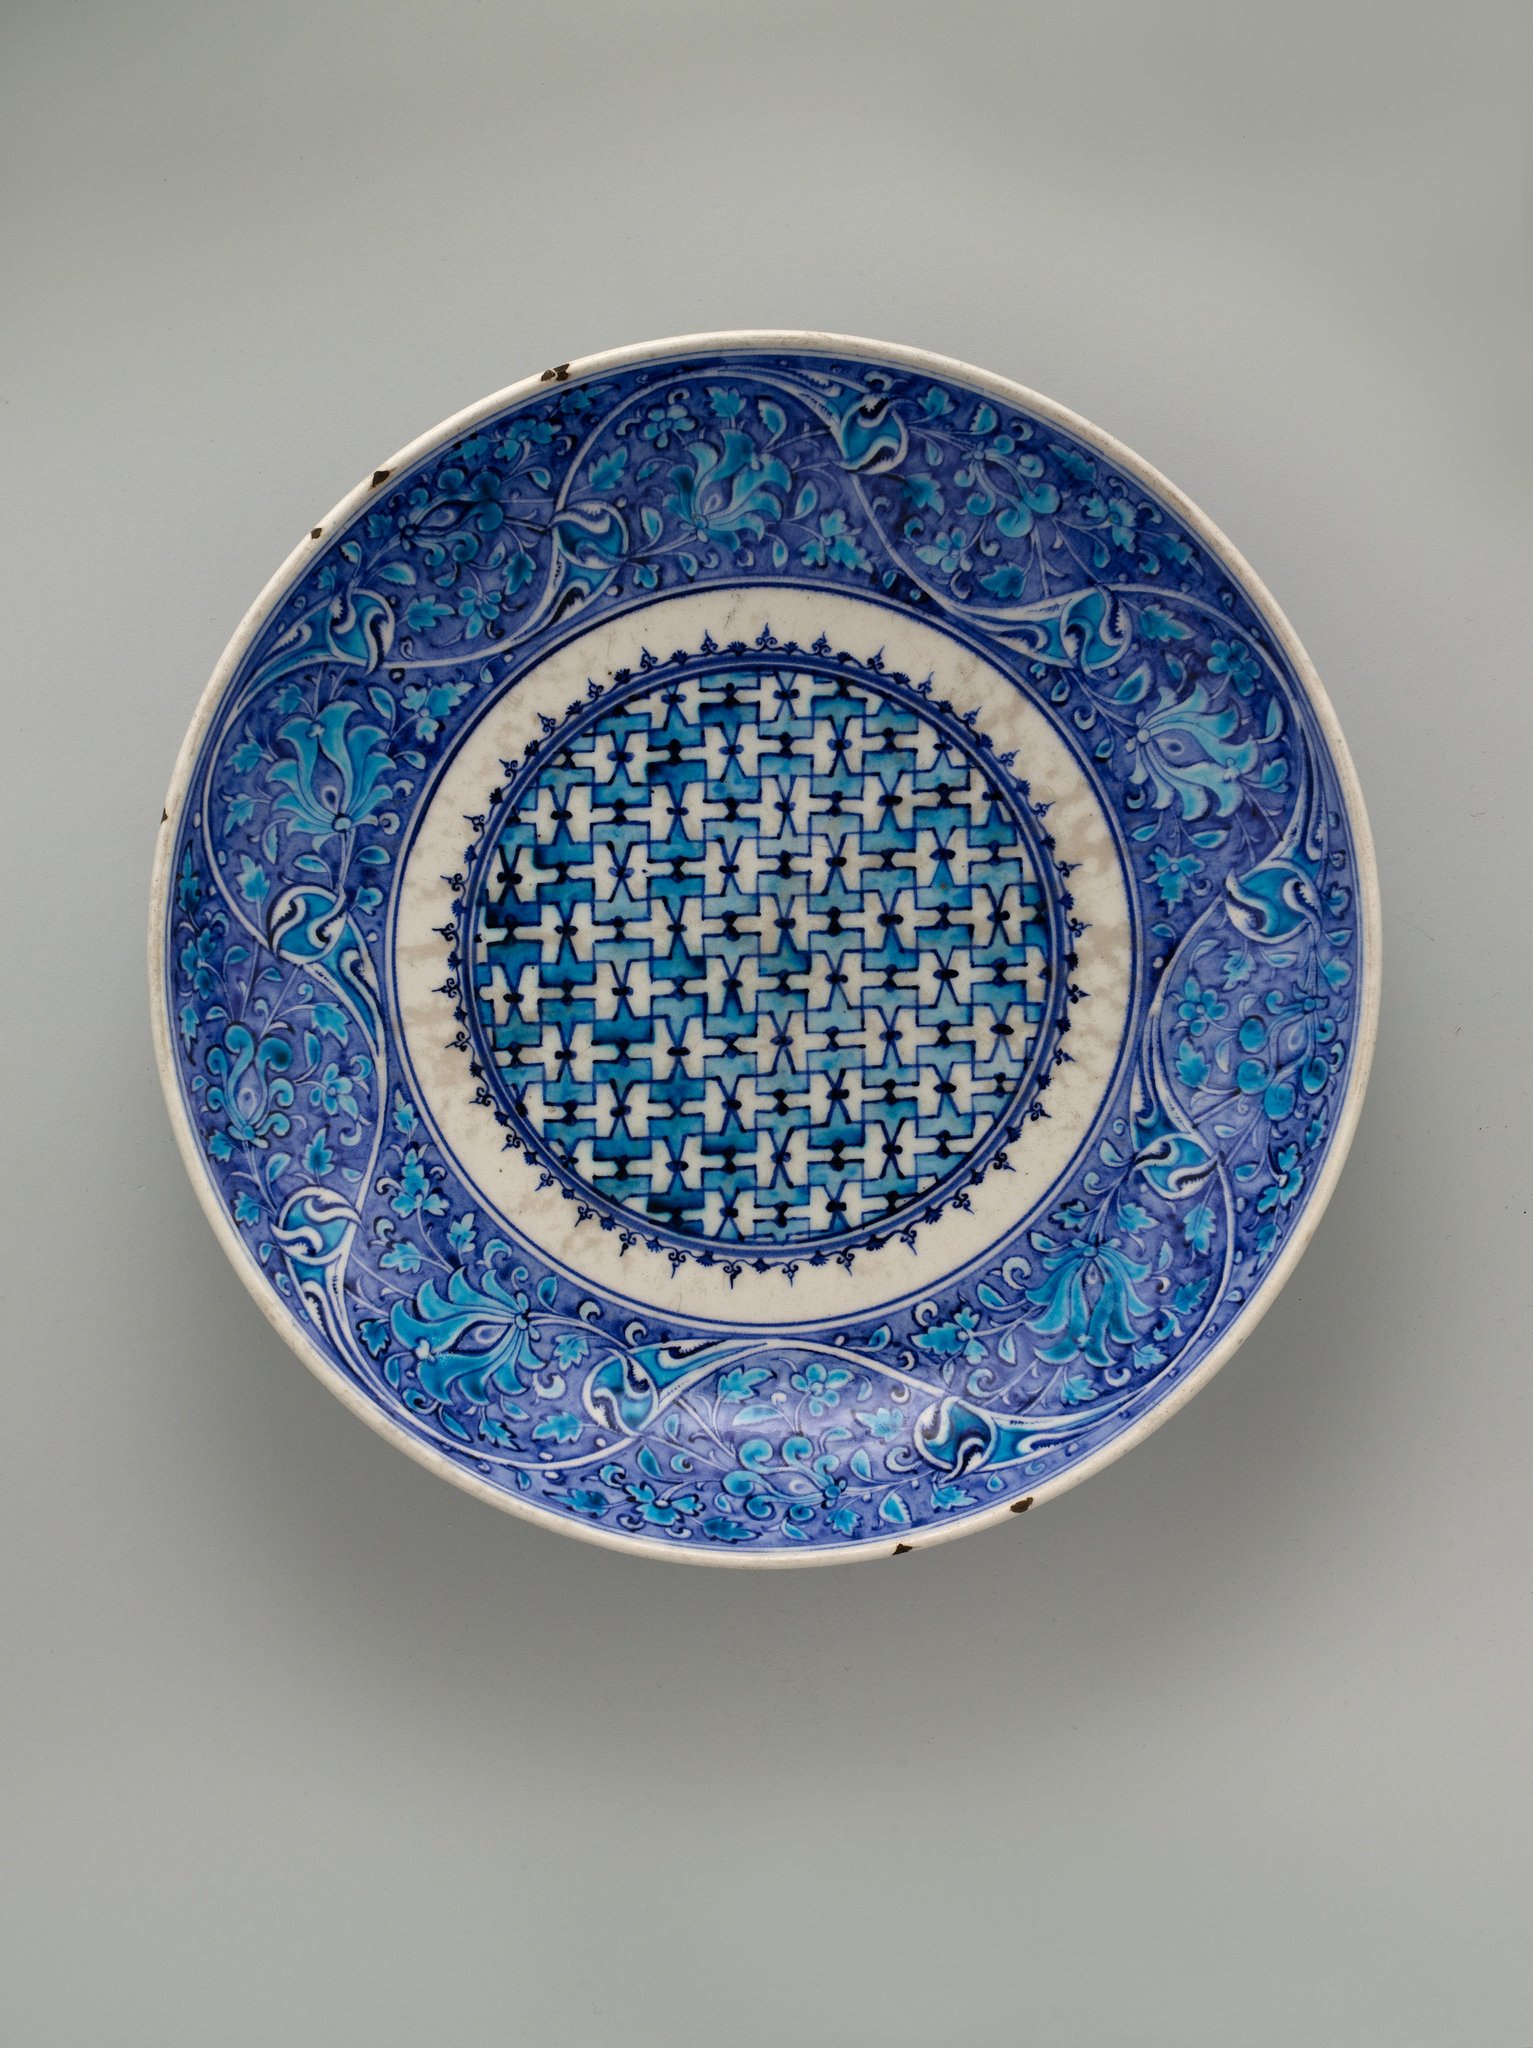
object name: dish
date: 1534-1566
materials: glaze, stonepaste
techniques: painting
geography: turkey